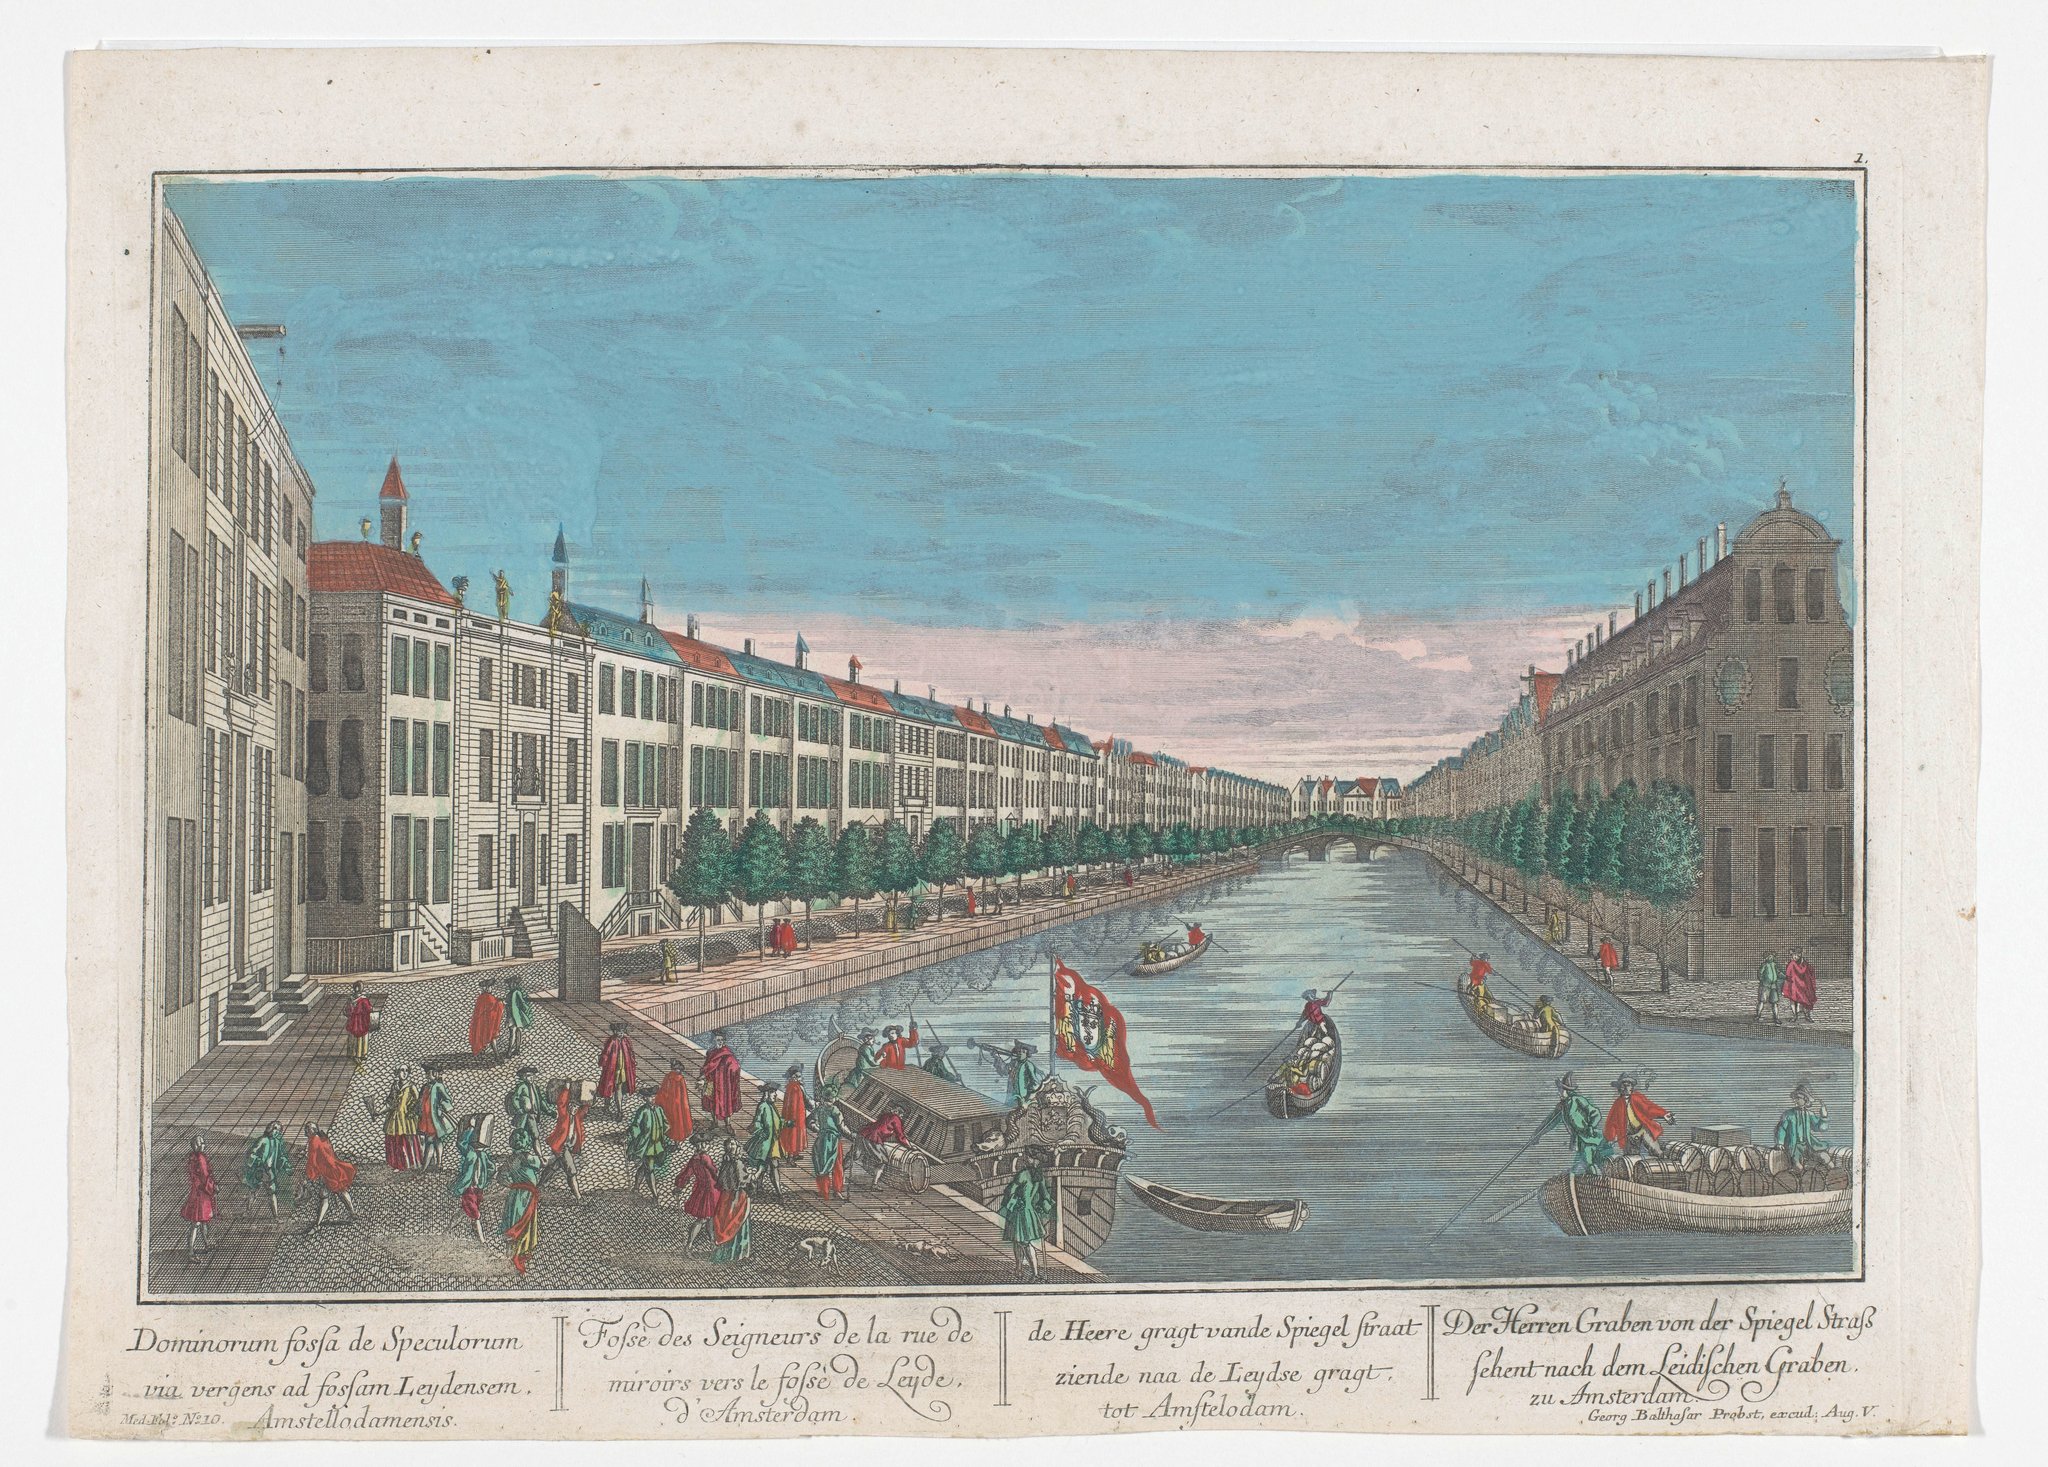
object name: print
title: Der Herren Graben von der Spiegel Straß sehent nach dem Leidischen Graben zu Amsterdam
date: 1766-1790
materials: paper, watercolor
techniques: brush, etching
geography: augsburg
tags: bridge in city across river, canal, etc. (+ city(-scape) with figures, staffage), rowing-boat, canoe, etc.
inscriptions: collector's mark: Lugt 2166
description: De serie “Amsterdam”, met het nummer 10, bevat vier prenten met de nummers 1-4, waarvan dit nummer 1 is.